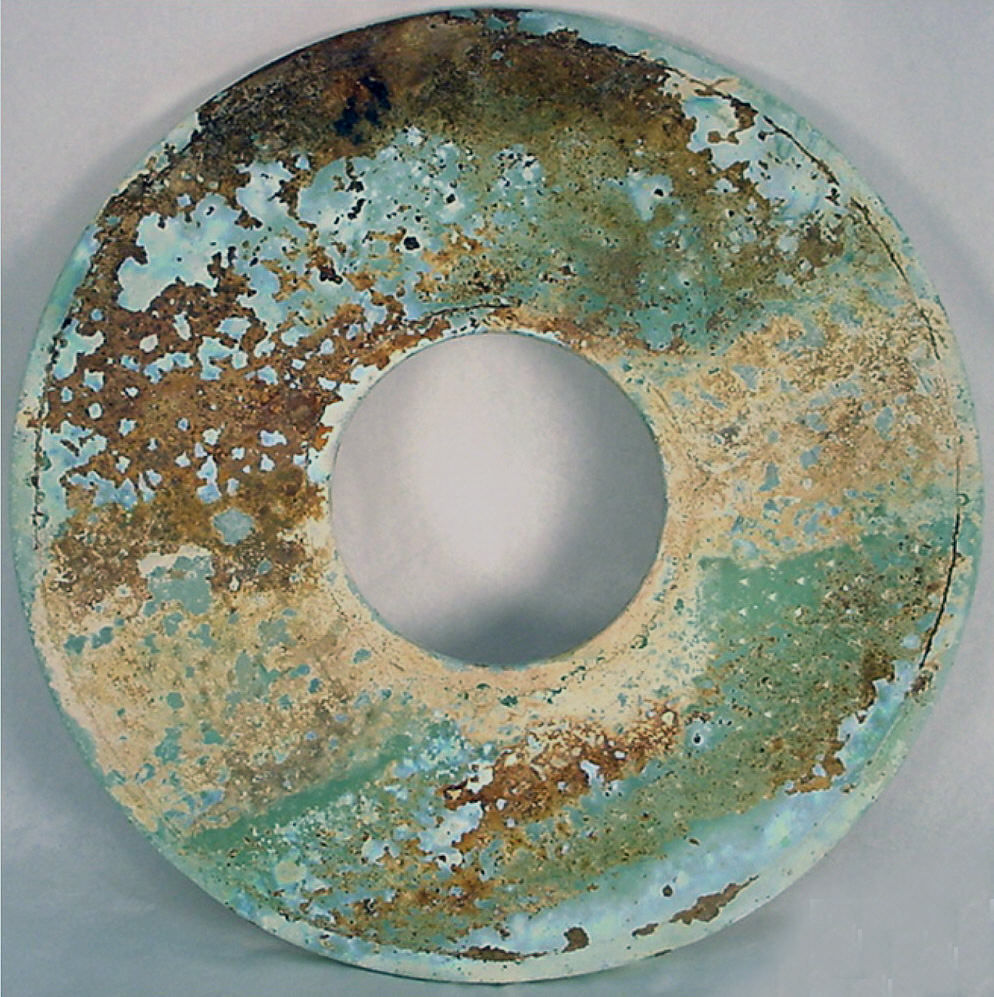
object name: disk bi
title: Disk (bi)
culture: chinese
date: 206 BCE-9 CE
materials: glass